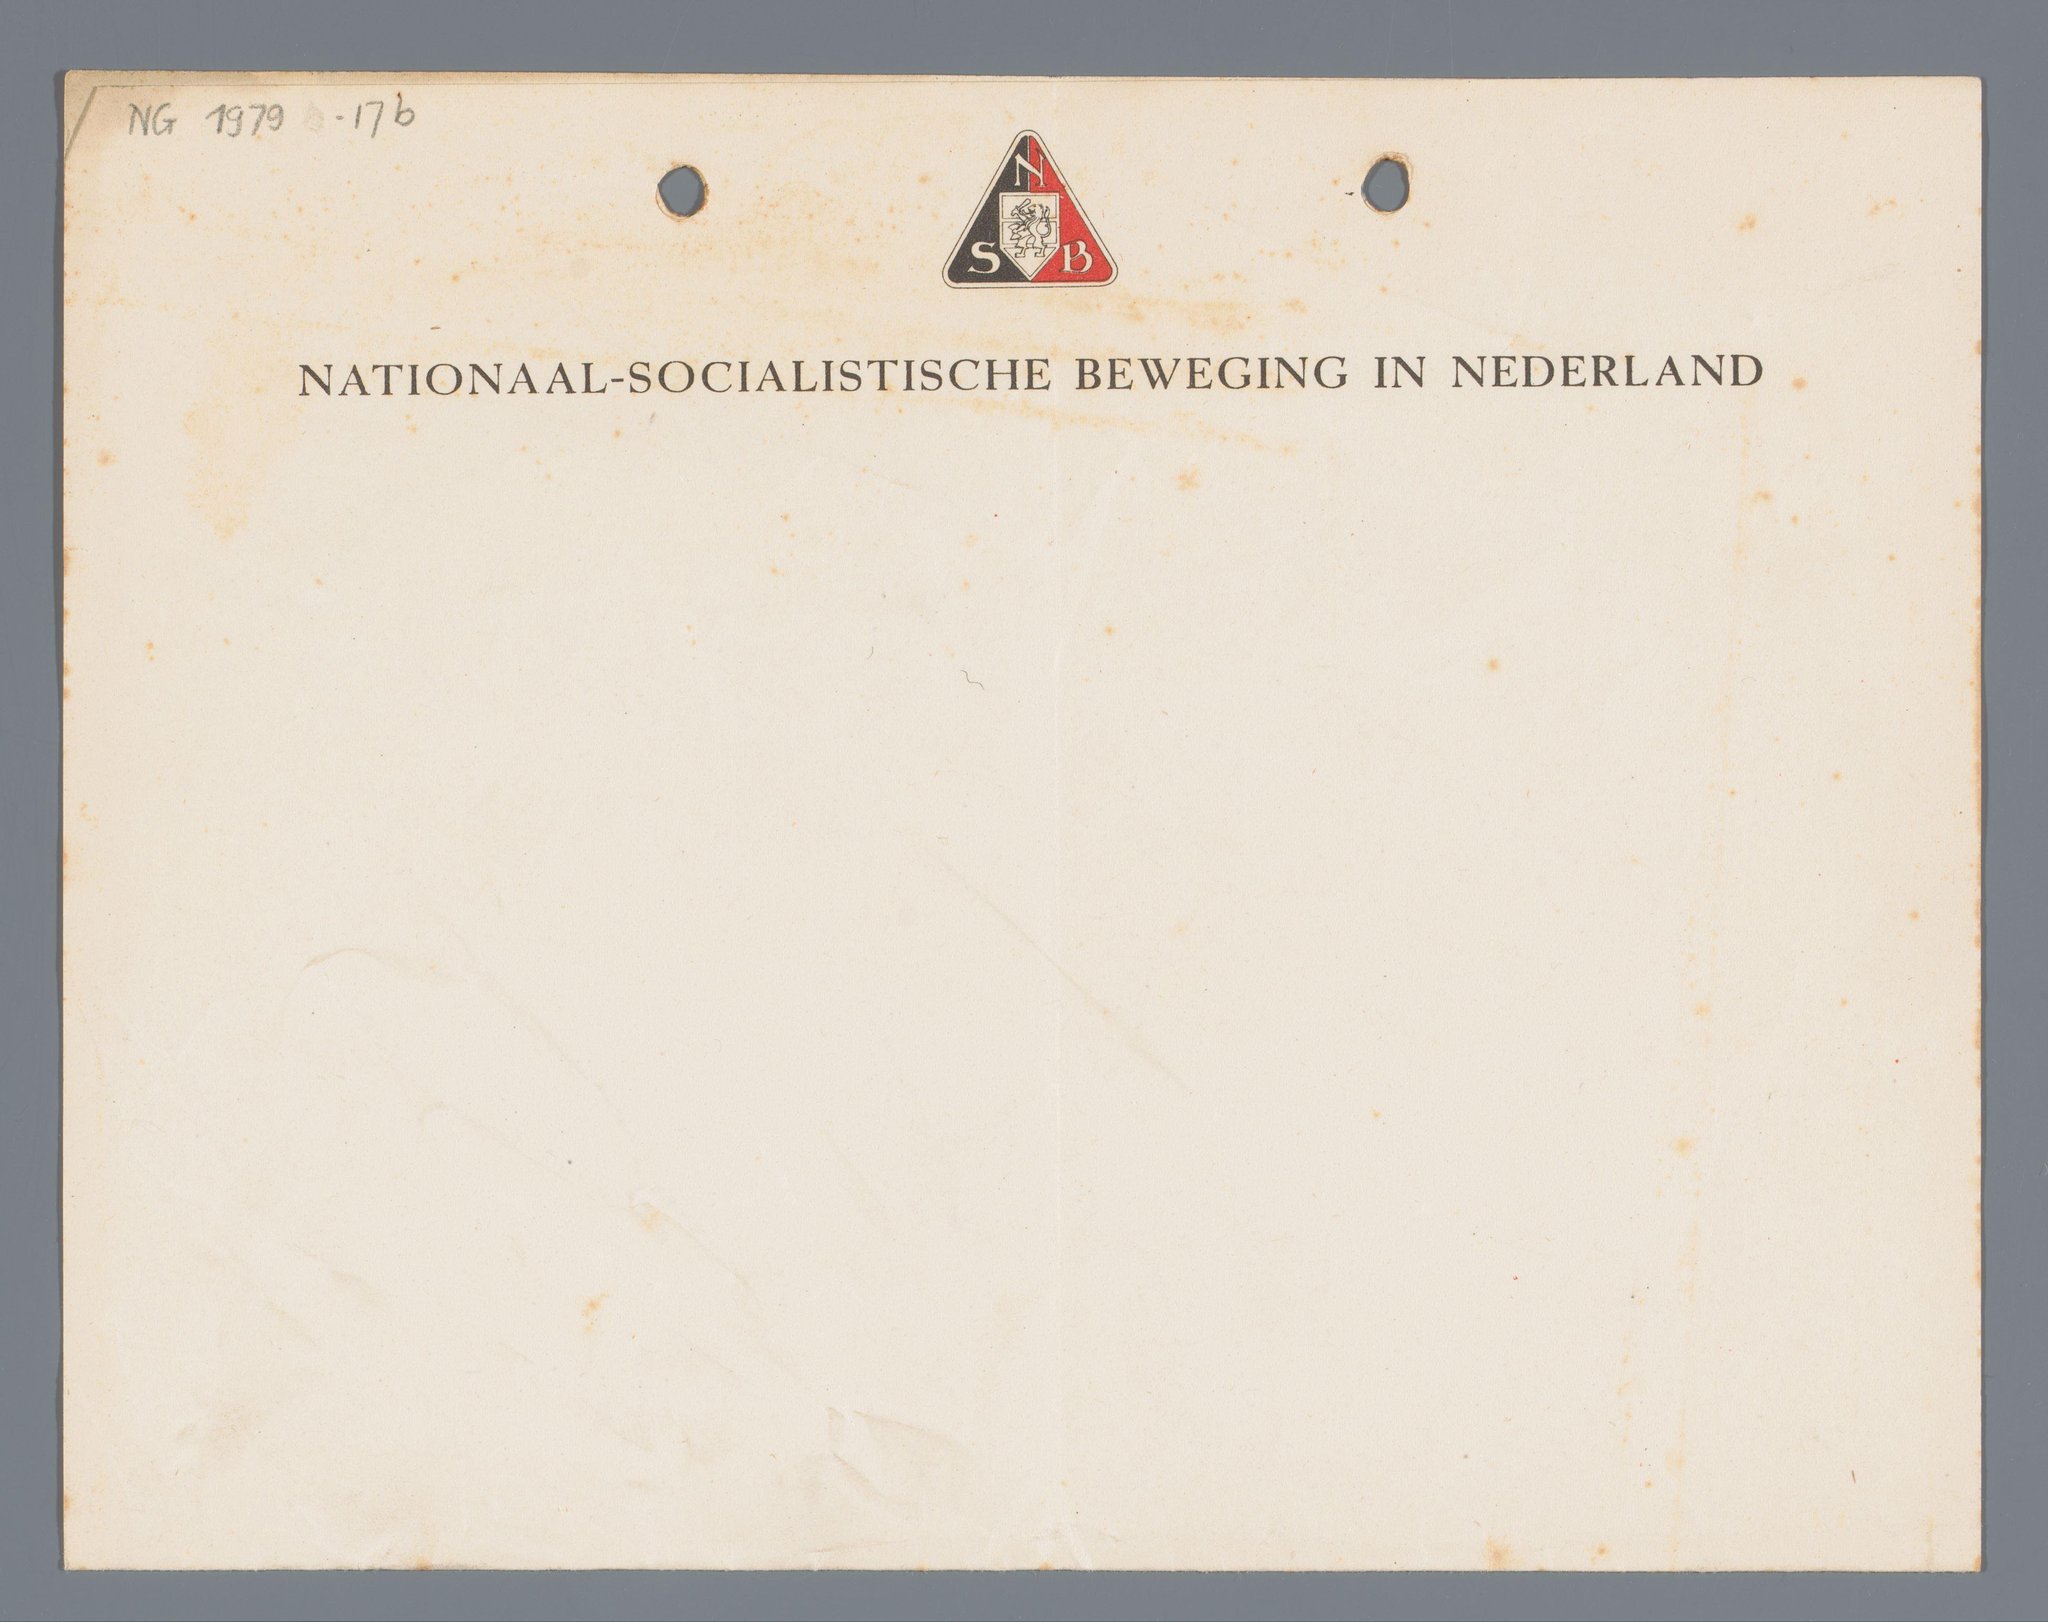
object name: stationery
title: Briefpapier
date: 1935-1945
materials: paper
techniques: printing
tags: netherlands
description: Blad papier met briefhoofd (van de NSB), met gaatjes aan de bovenkant. Opschrift: NSB / Nationaal-Socialistische Beweging in Nederland.